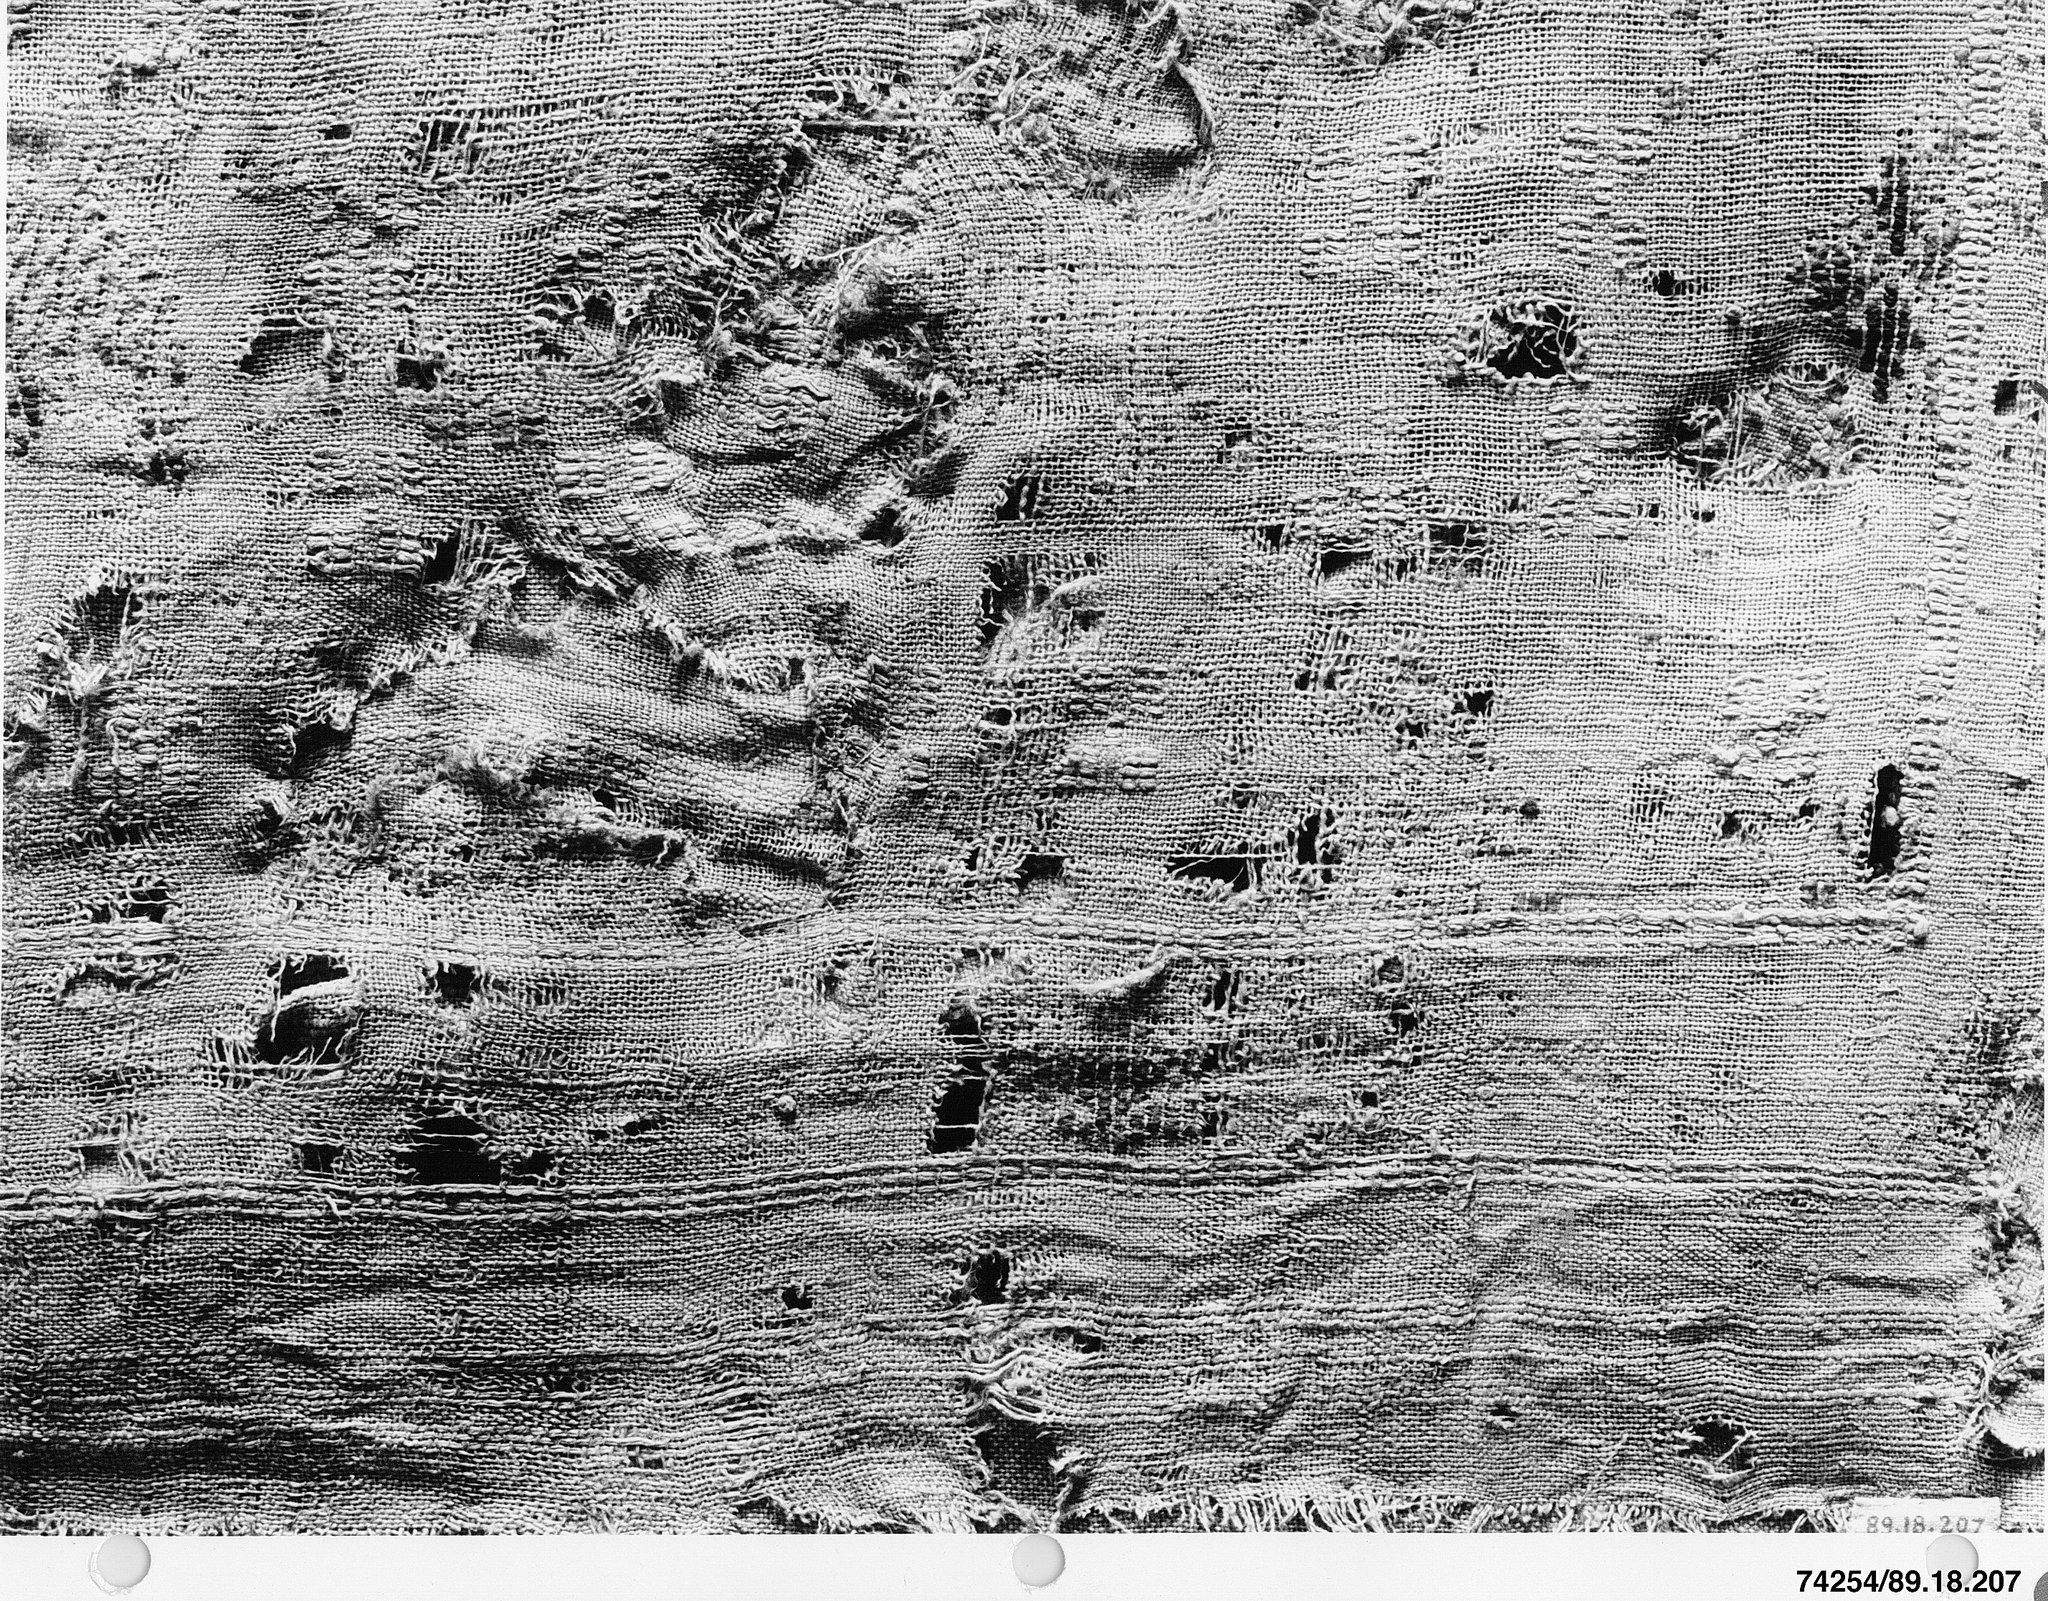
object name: textile fragment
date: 301-500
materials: linen, wool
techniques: weave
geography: egypt